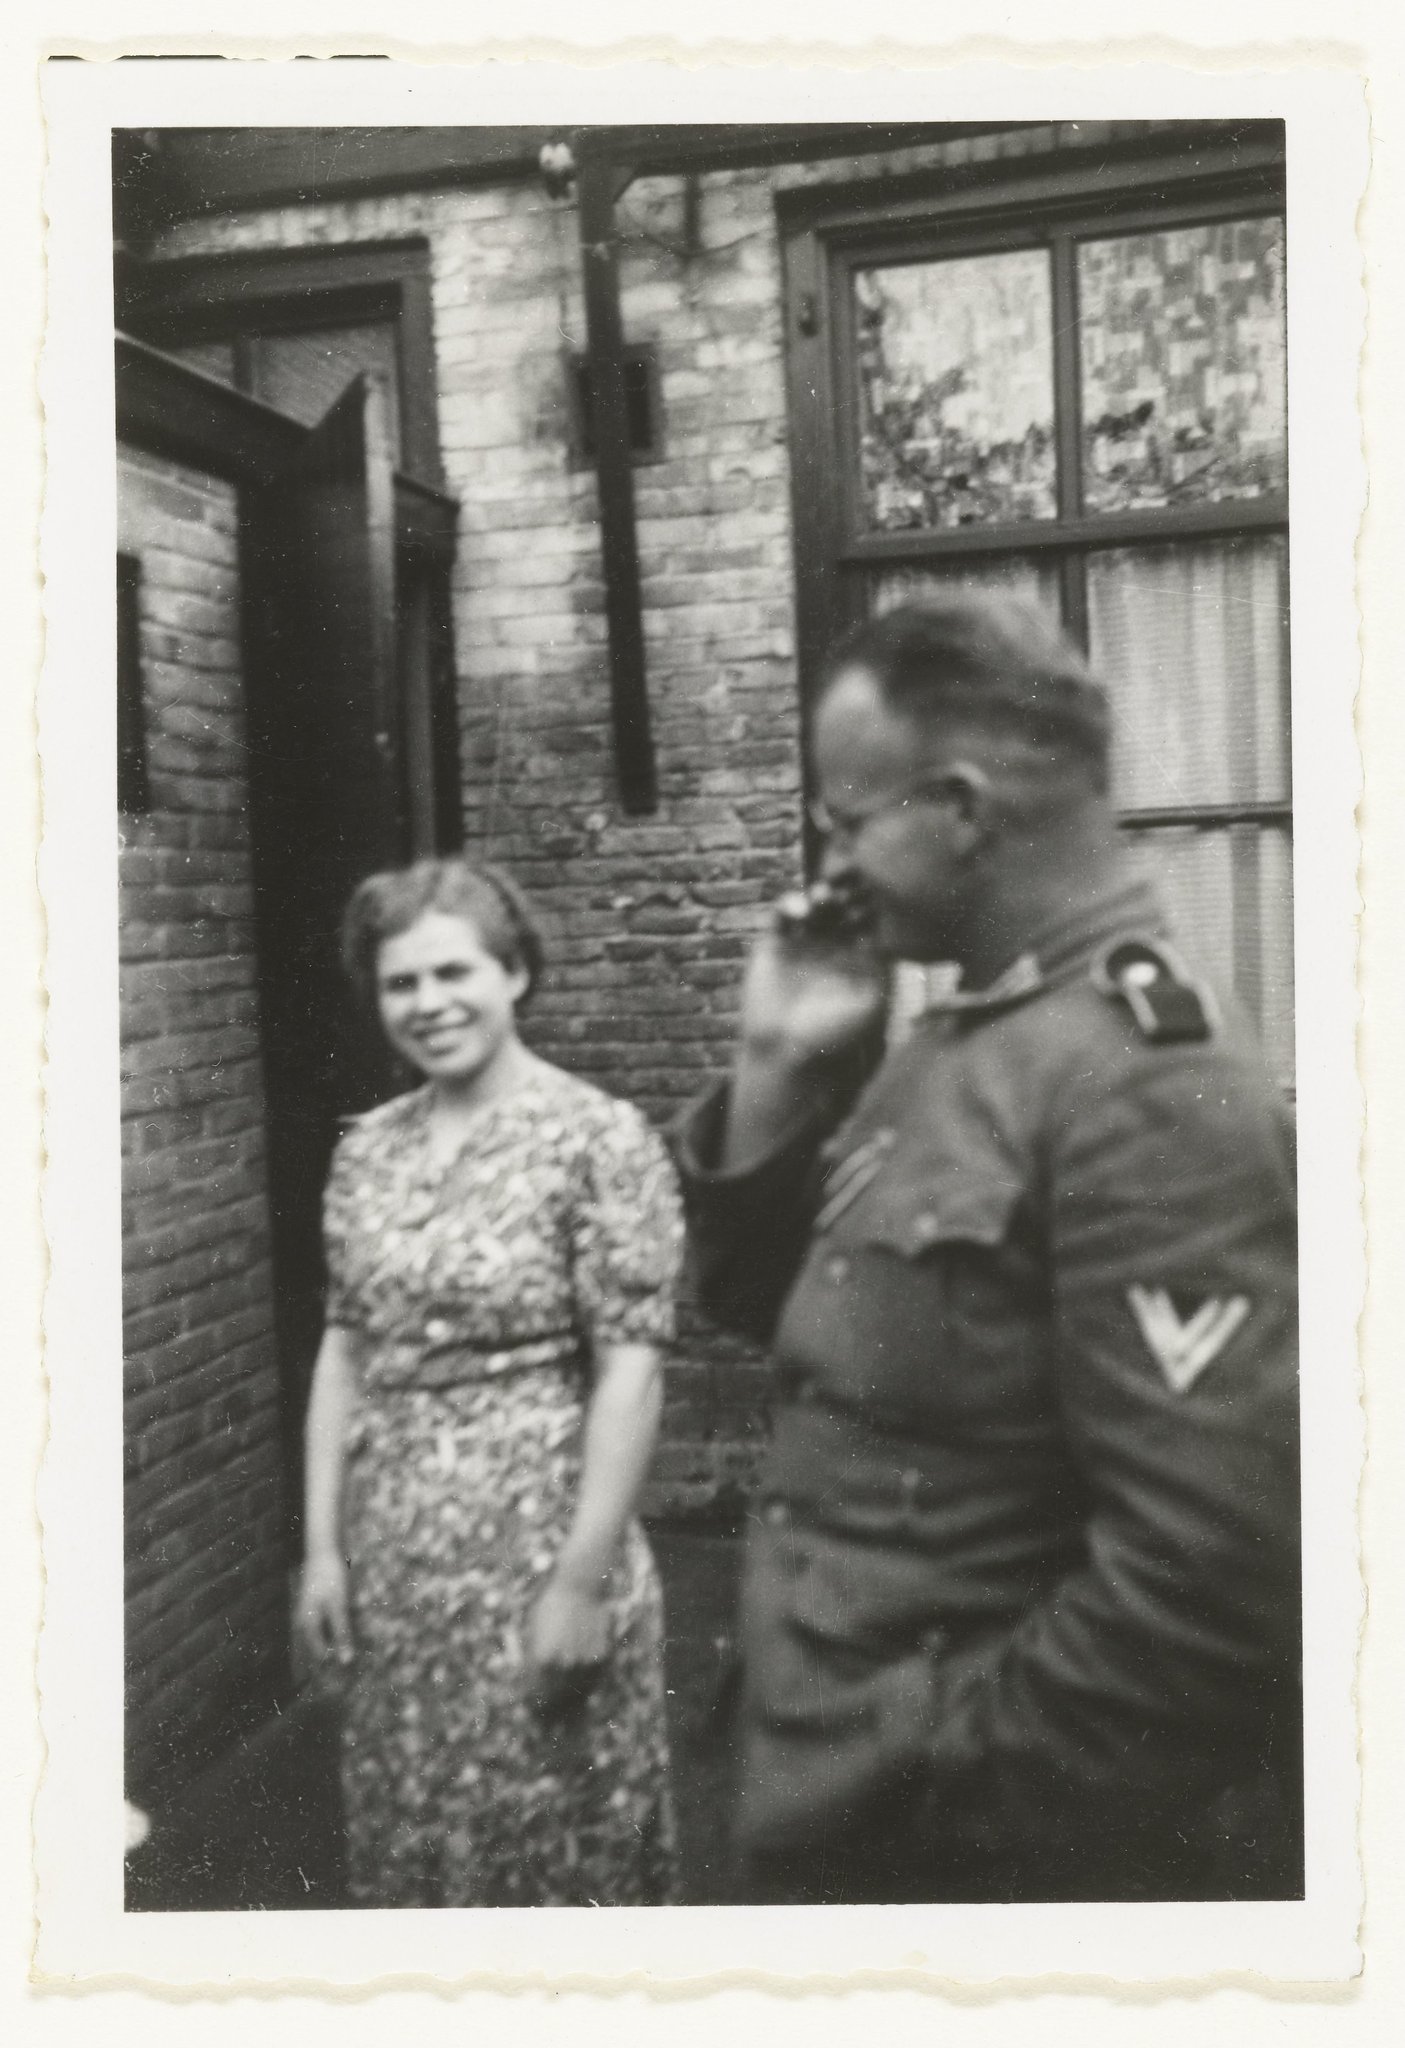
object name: photograph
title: Wehrmachtsoldaat Nederlandse vrouw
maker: Anonymous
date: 1909-1940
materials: photographic support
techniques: gelatin silver print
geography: raamsdonksveer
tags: occupier and civilians, occupation ~ war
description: Een Duitse militair met een Nederlandse vrouw bij een huis in Raamsdonksveer. Achterop staat: Holland Sept. 1940. Hermann Ricklets und Adriane Gamers.